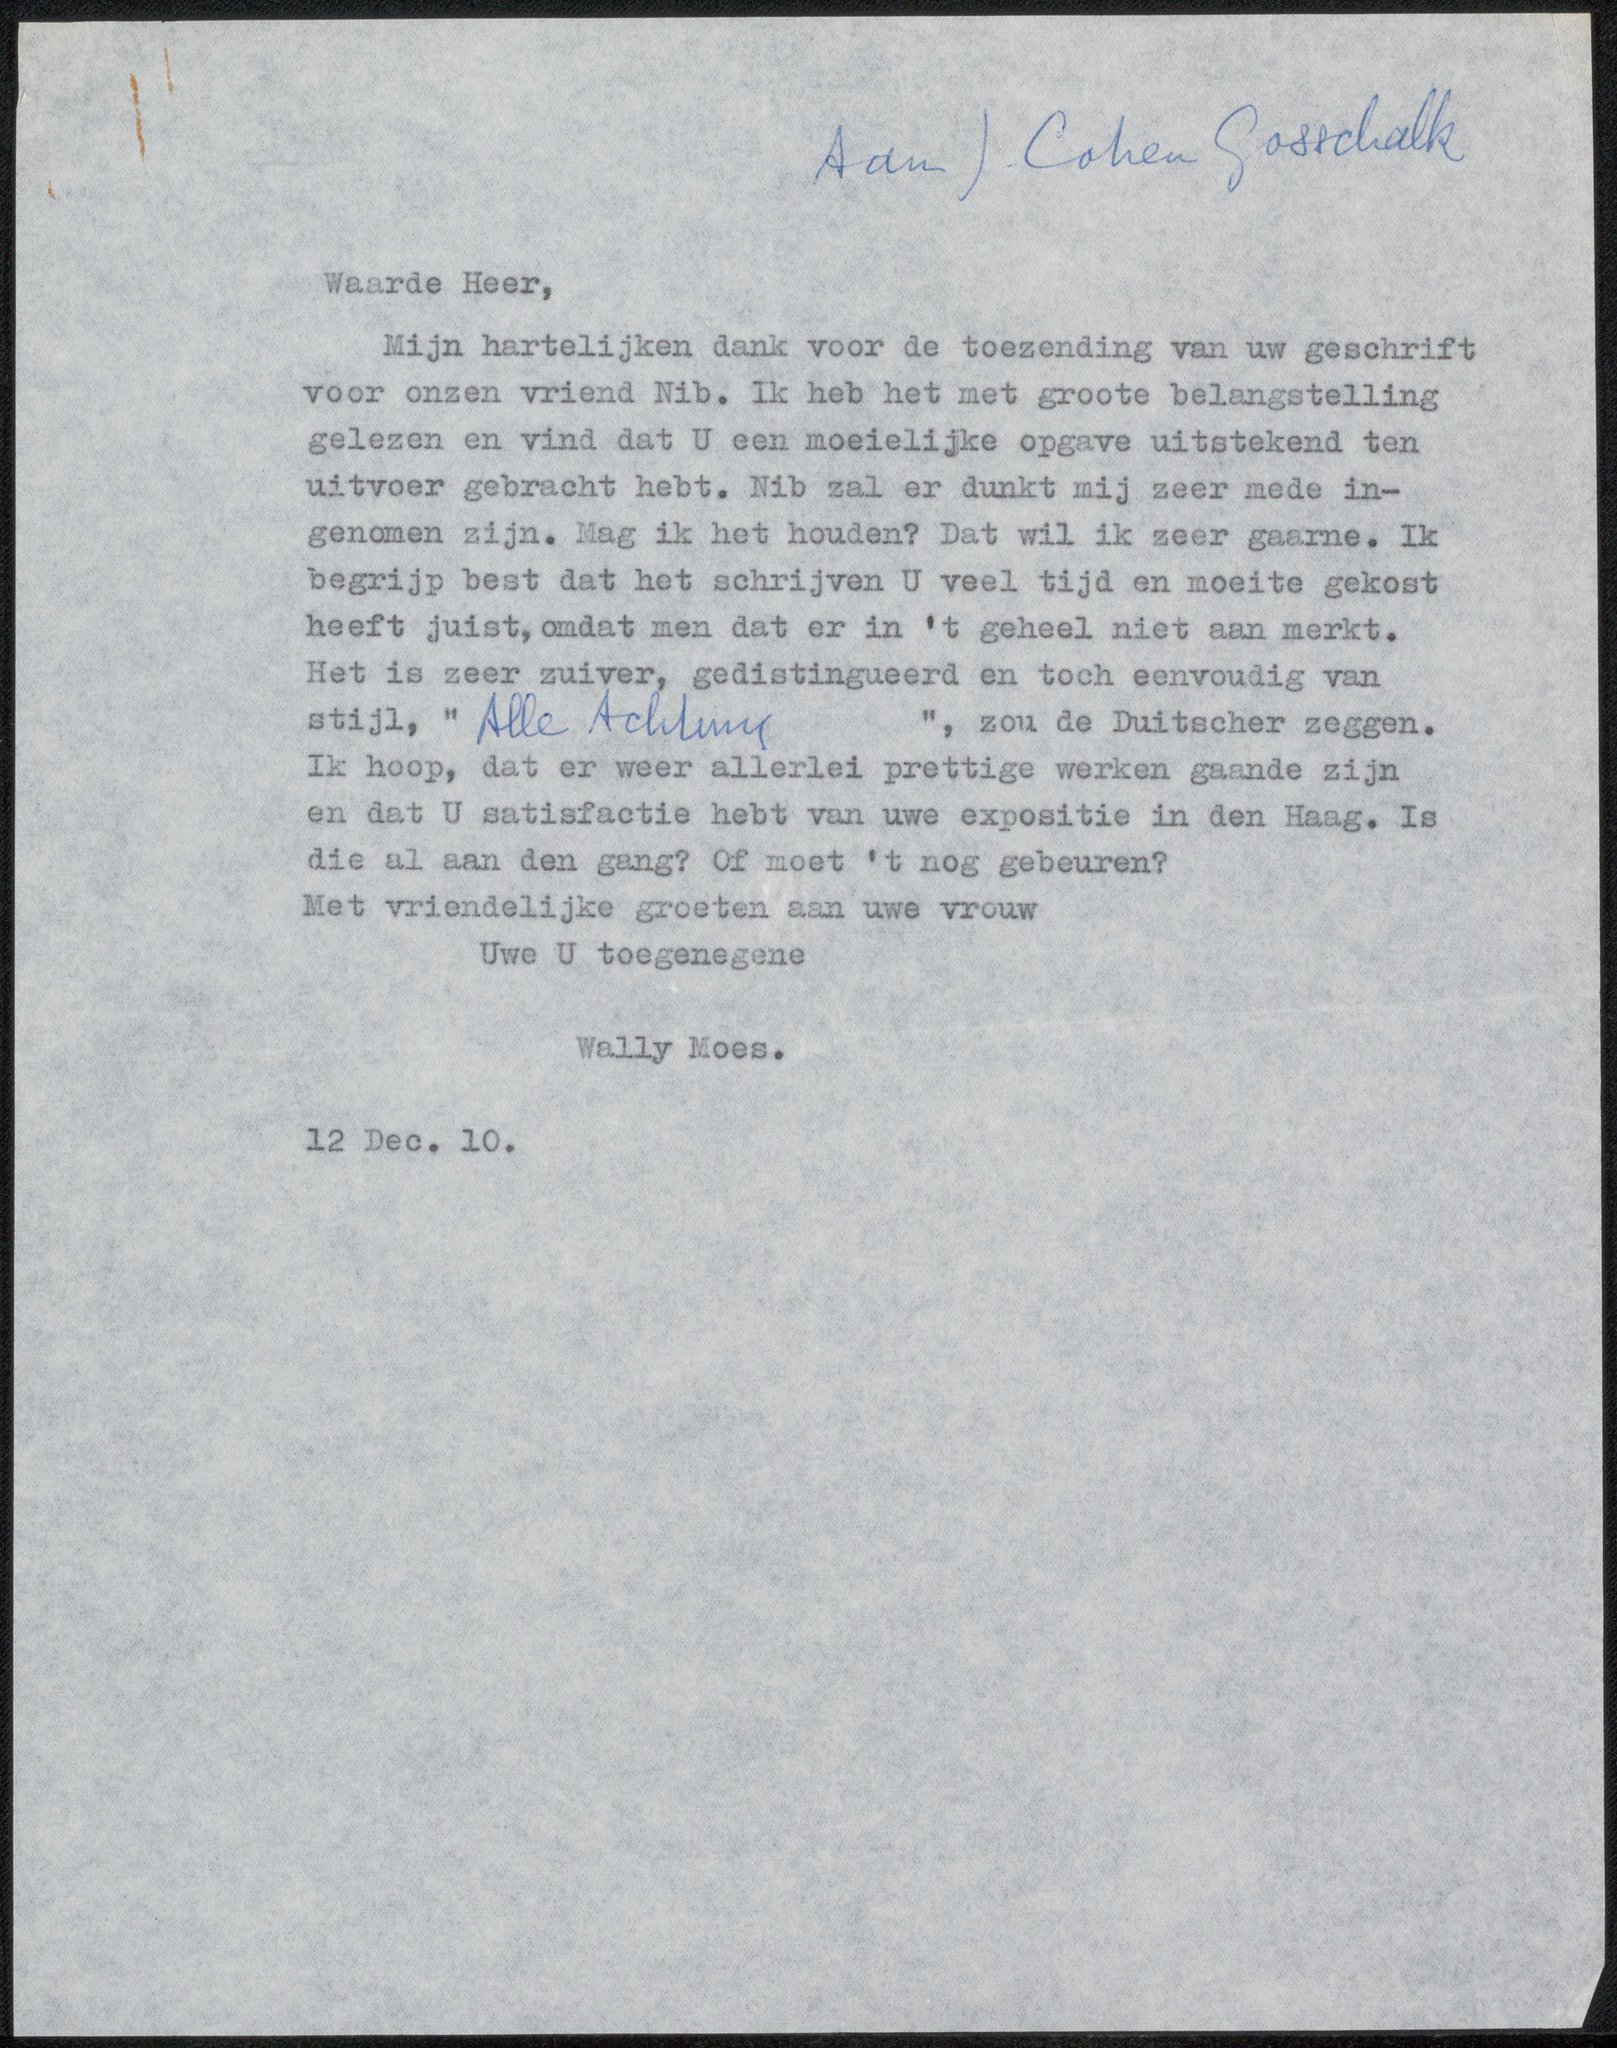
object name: letter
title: Brief aan Johan Henri Gustaaf Cohen Gosschalk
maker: wally moes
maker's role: draughtsman, print maker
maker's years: 1856-1918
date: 1910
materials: ink, paper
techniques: pen, typewriting, writing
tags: amsterdam, print maker, draughtsman, johan henri gustaaf cohen gosschalk, painter, ferdinand hart nibbrig, exhibition ~ art, printed matter, the hague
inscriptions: collector's mark: ‘RPK’